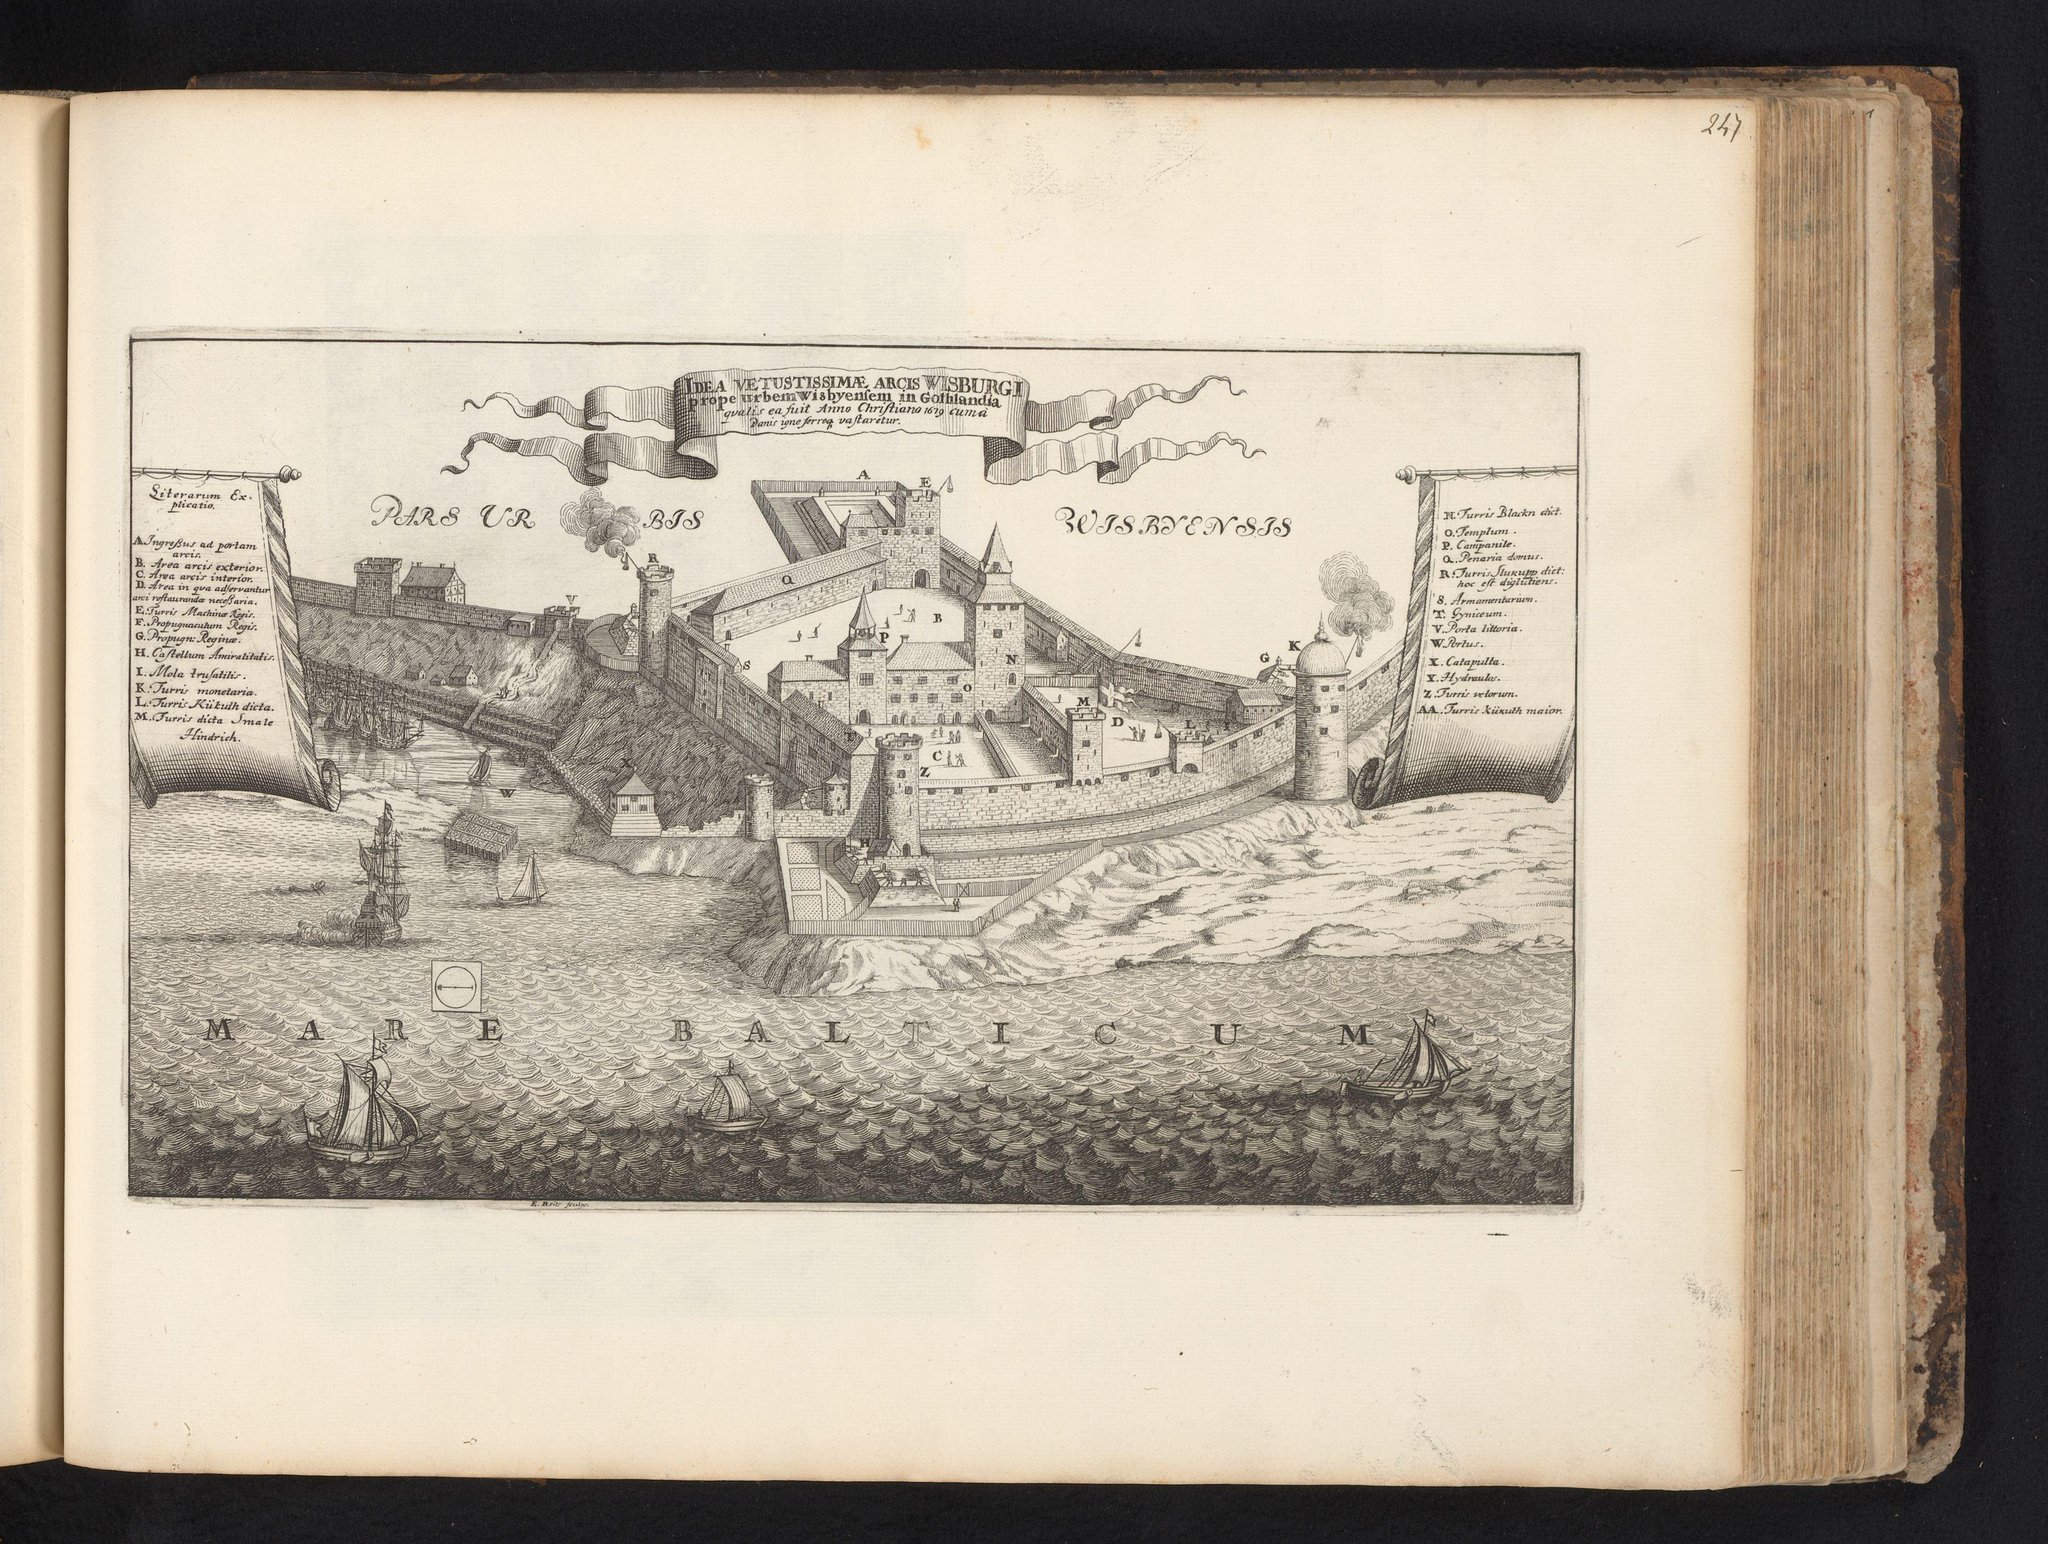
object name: print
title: Suecia Antiqua et Hodierna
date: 1693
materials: paper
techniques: etching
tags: castle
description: Kungliga Biblioteket, 'Suecia': http://www.kb.se/samlingarna/Kartor-bilder/Suecia-antiqua/ (geraadpleegd november 2016).